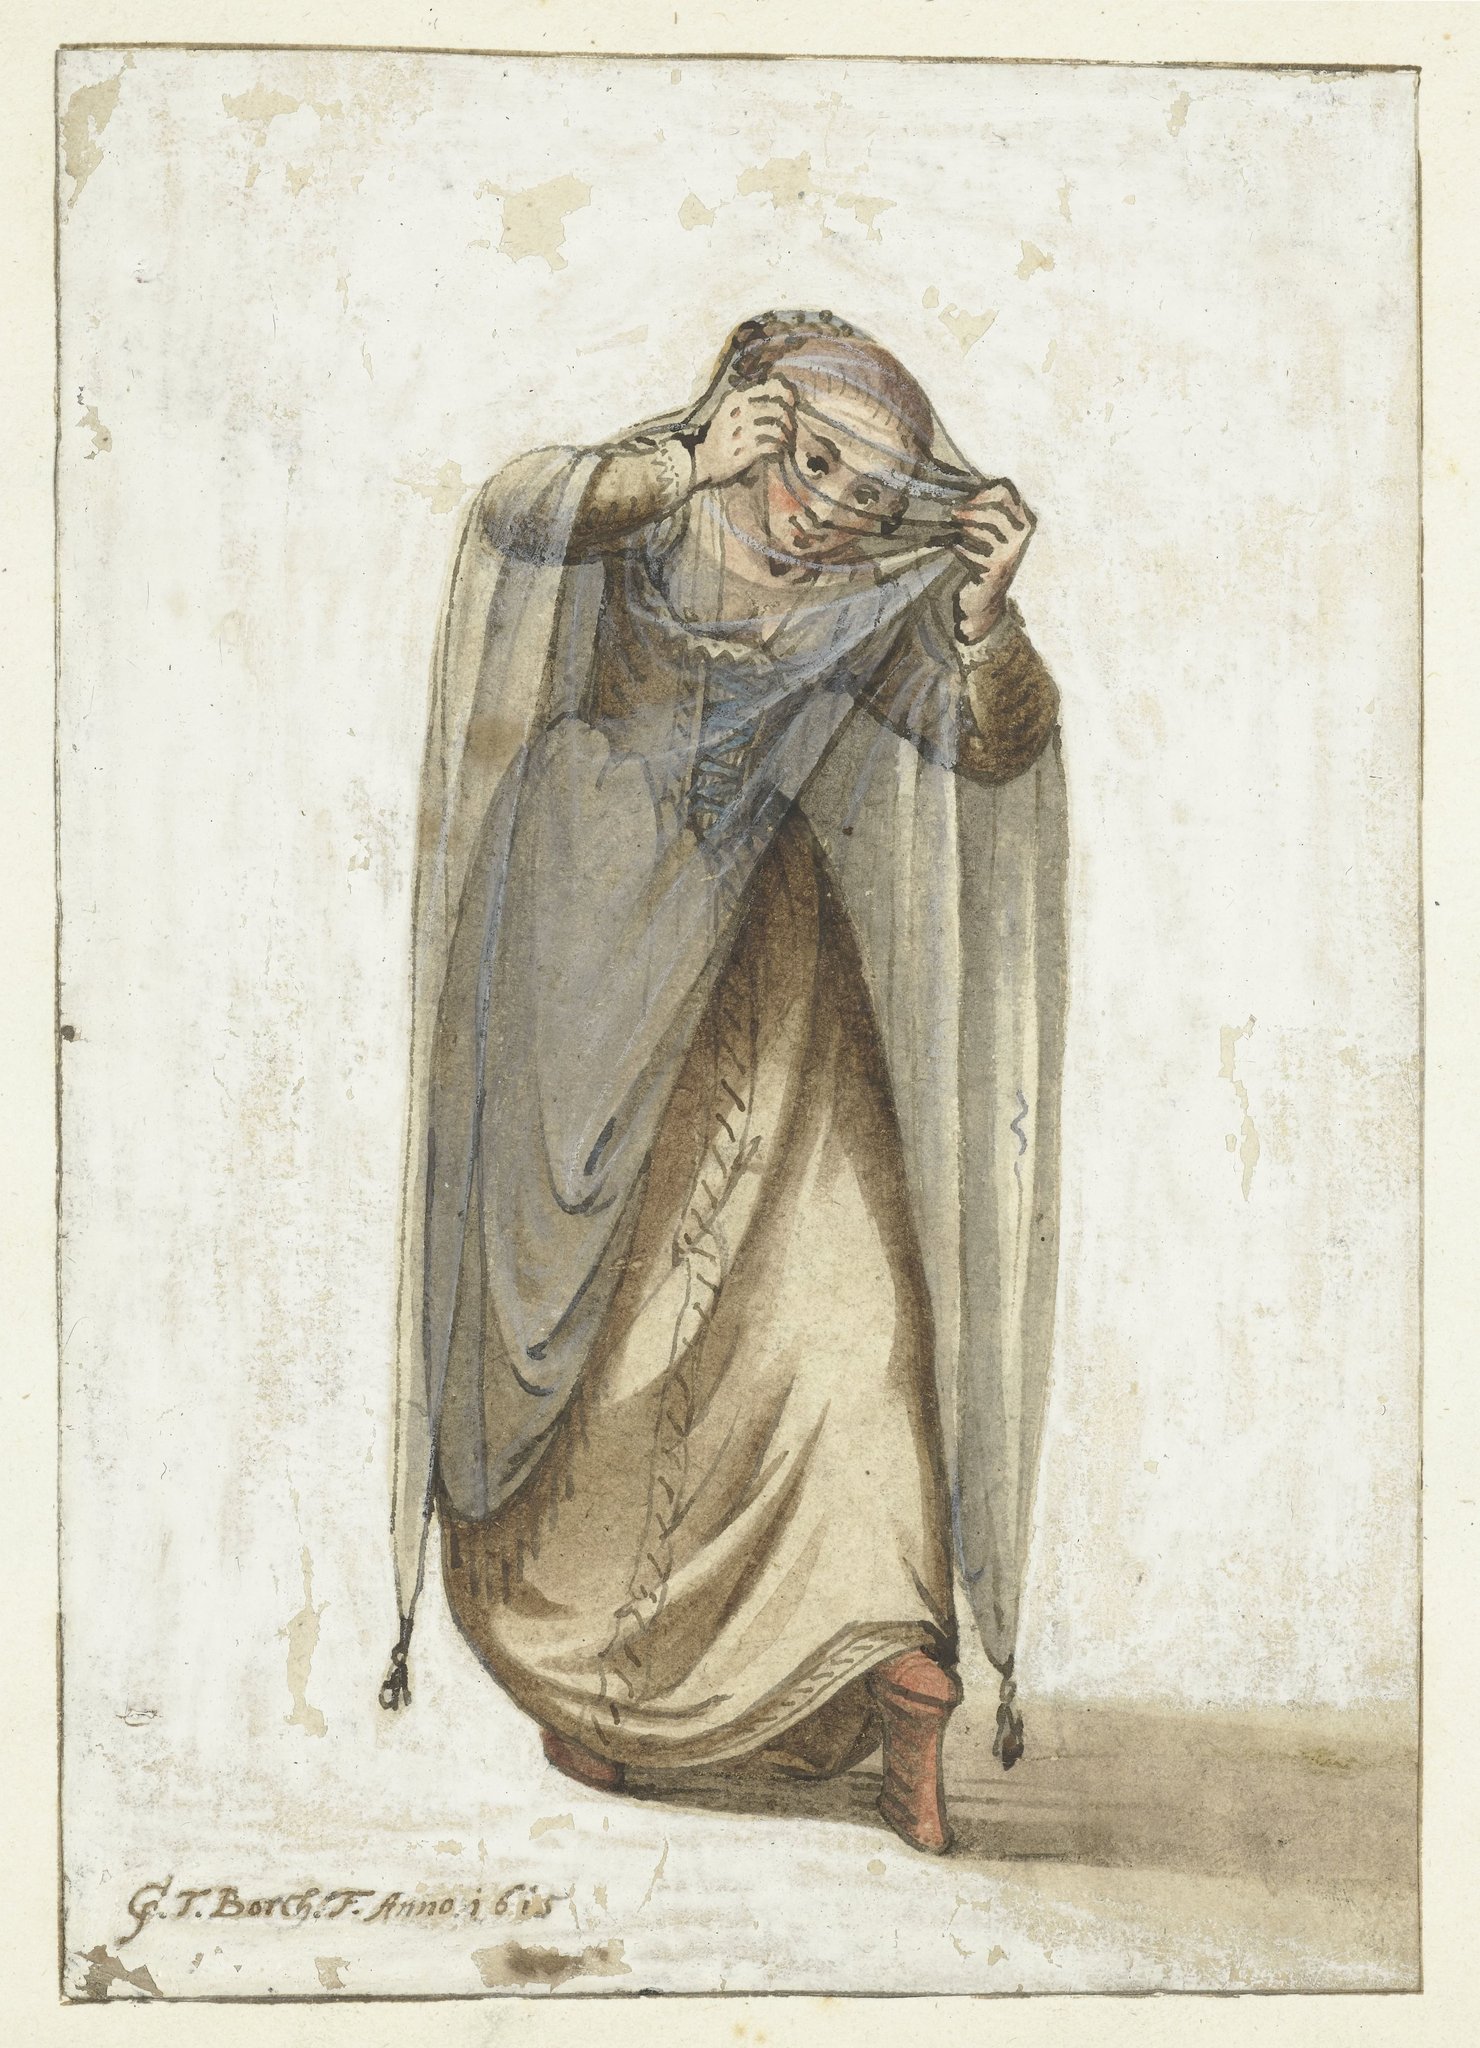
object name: drawing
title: Venetiaanse courtisane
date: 1660-1687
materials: paint, paper, watercolor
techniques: brush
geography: zwolle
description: Kopie naar 15e eeuwse tekening toegeschreven aan de omgeving van Gentile Bellini. De tekening is naast twee andere tekeningen opgeplakt in het album.